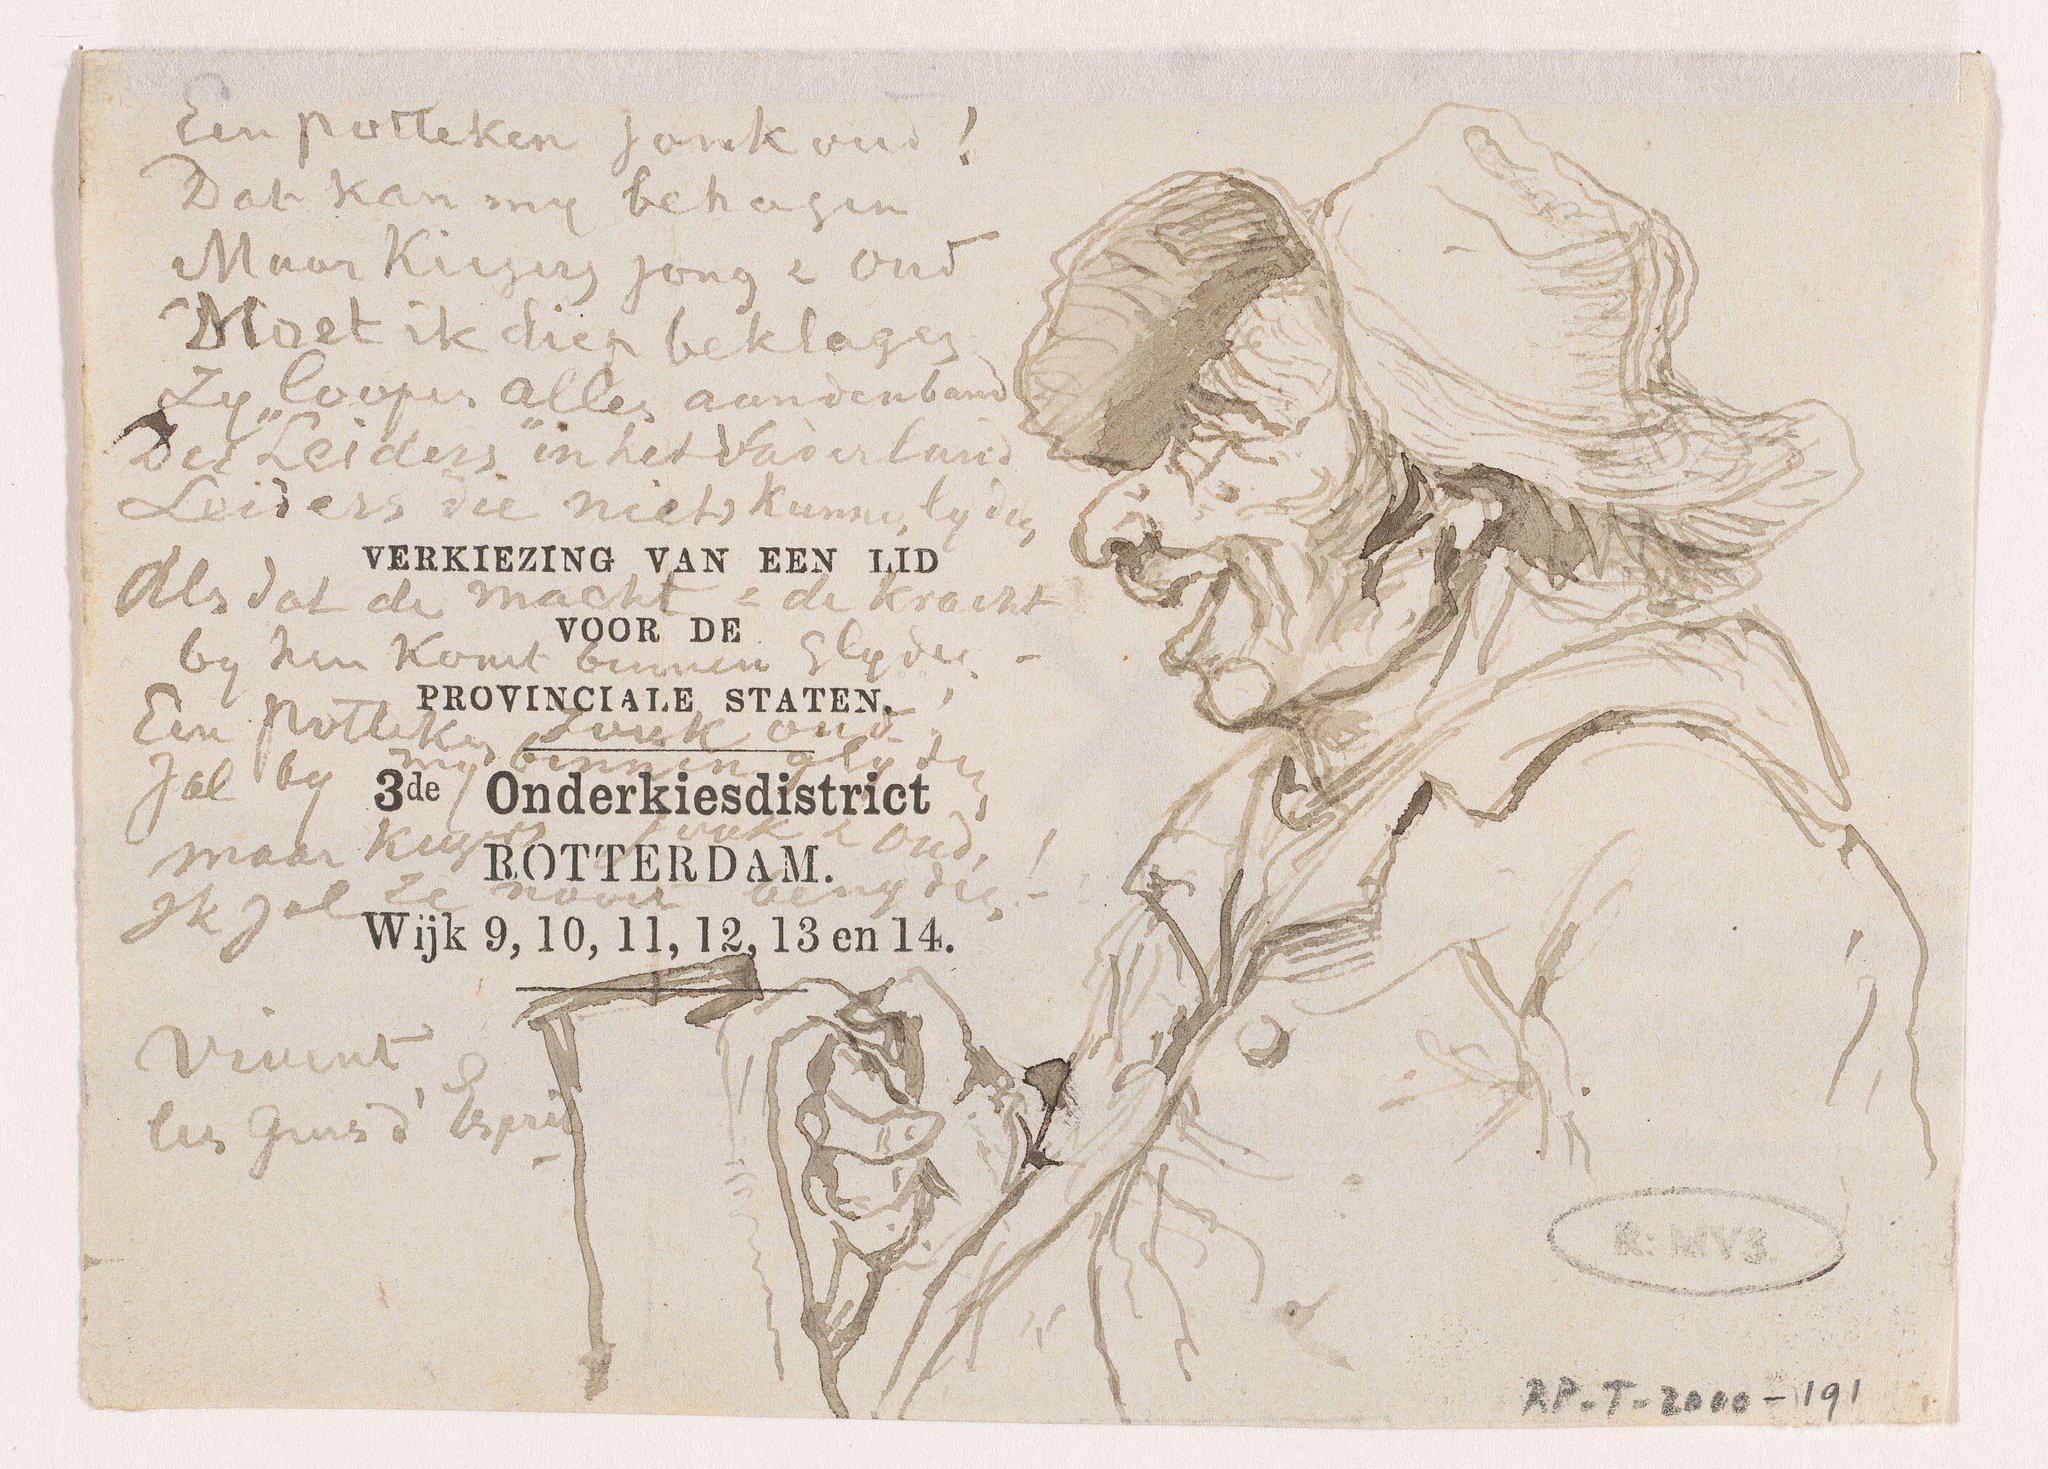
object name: drawing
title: Drinkende boer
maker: johannes tavenraat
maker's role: draughtsman, painter, print maker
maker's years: 1809-1881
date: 1840-1880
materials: ink, paper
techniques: brush, pen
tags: caricatures (human types), alcoholic drinks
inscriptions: collector's mark: Lugt 2228, annotation: ‘Een potteken ... Vincent / les gens d'esprit’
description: Drinkende lachende boer met pul in de hand. Hierbij de tekst van een vers of lied. Getekend op een deel van een stembiljet voor de verkiezing van een een lid van de Provinciale Staten uit Rotterdam.